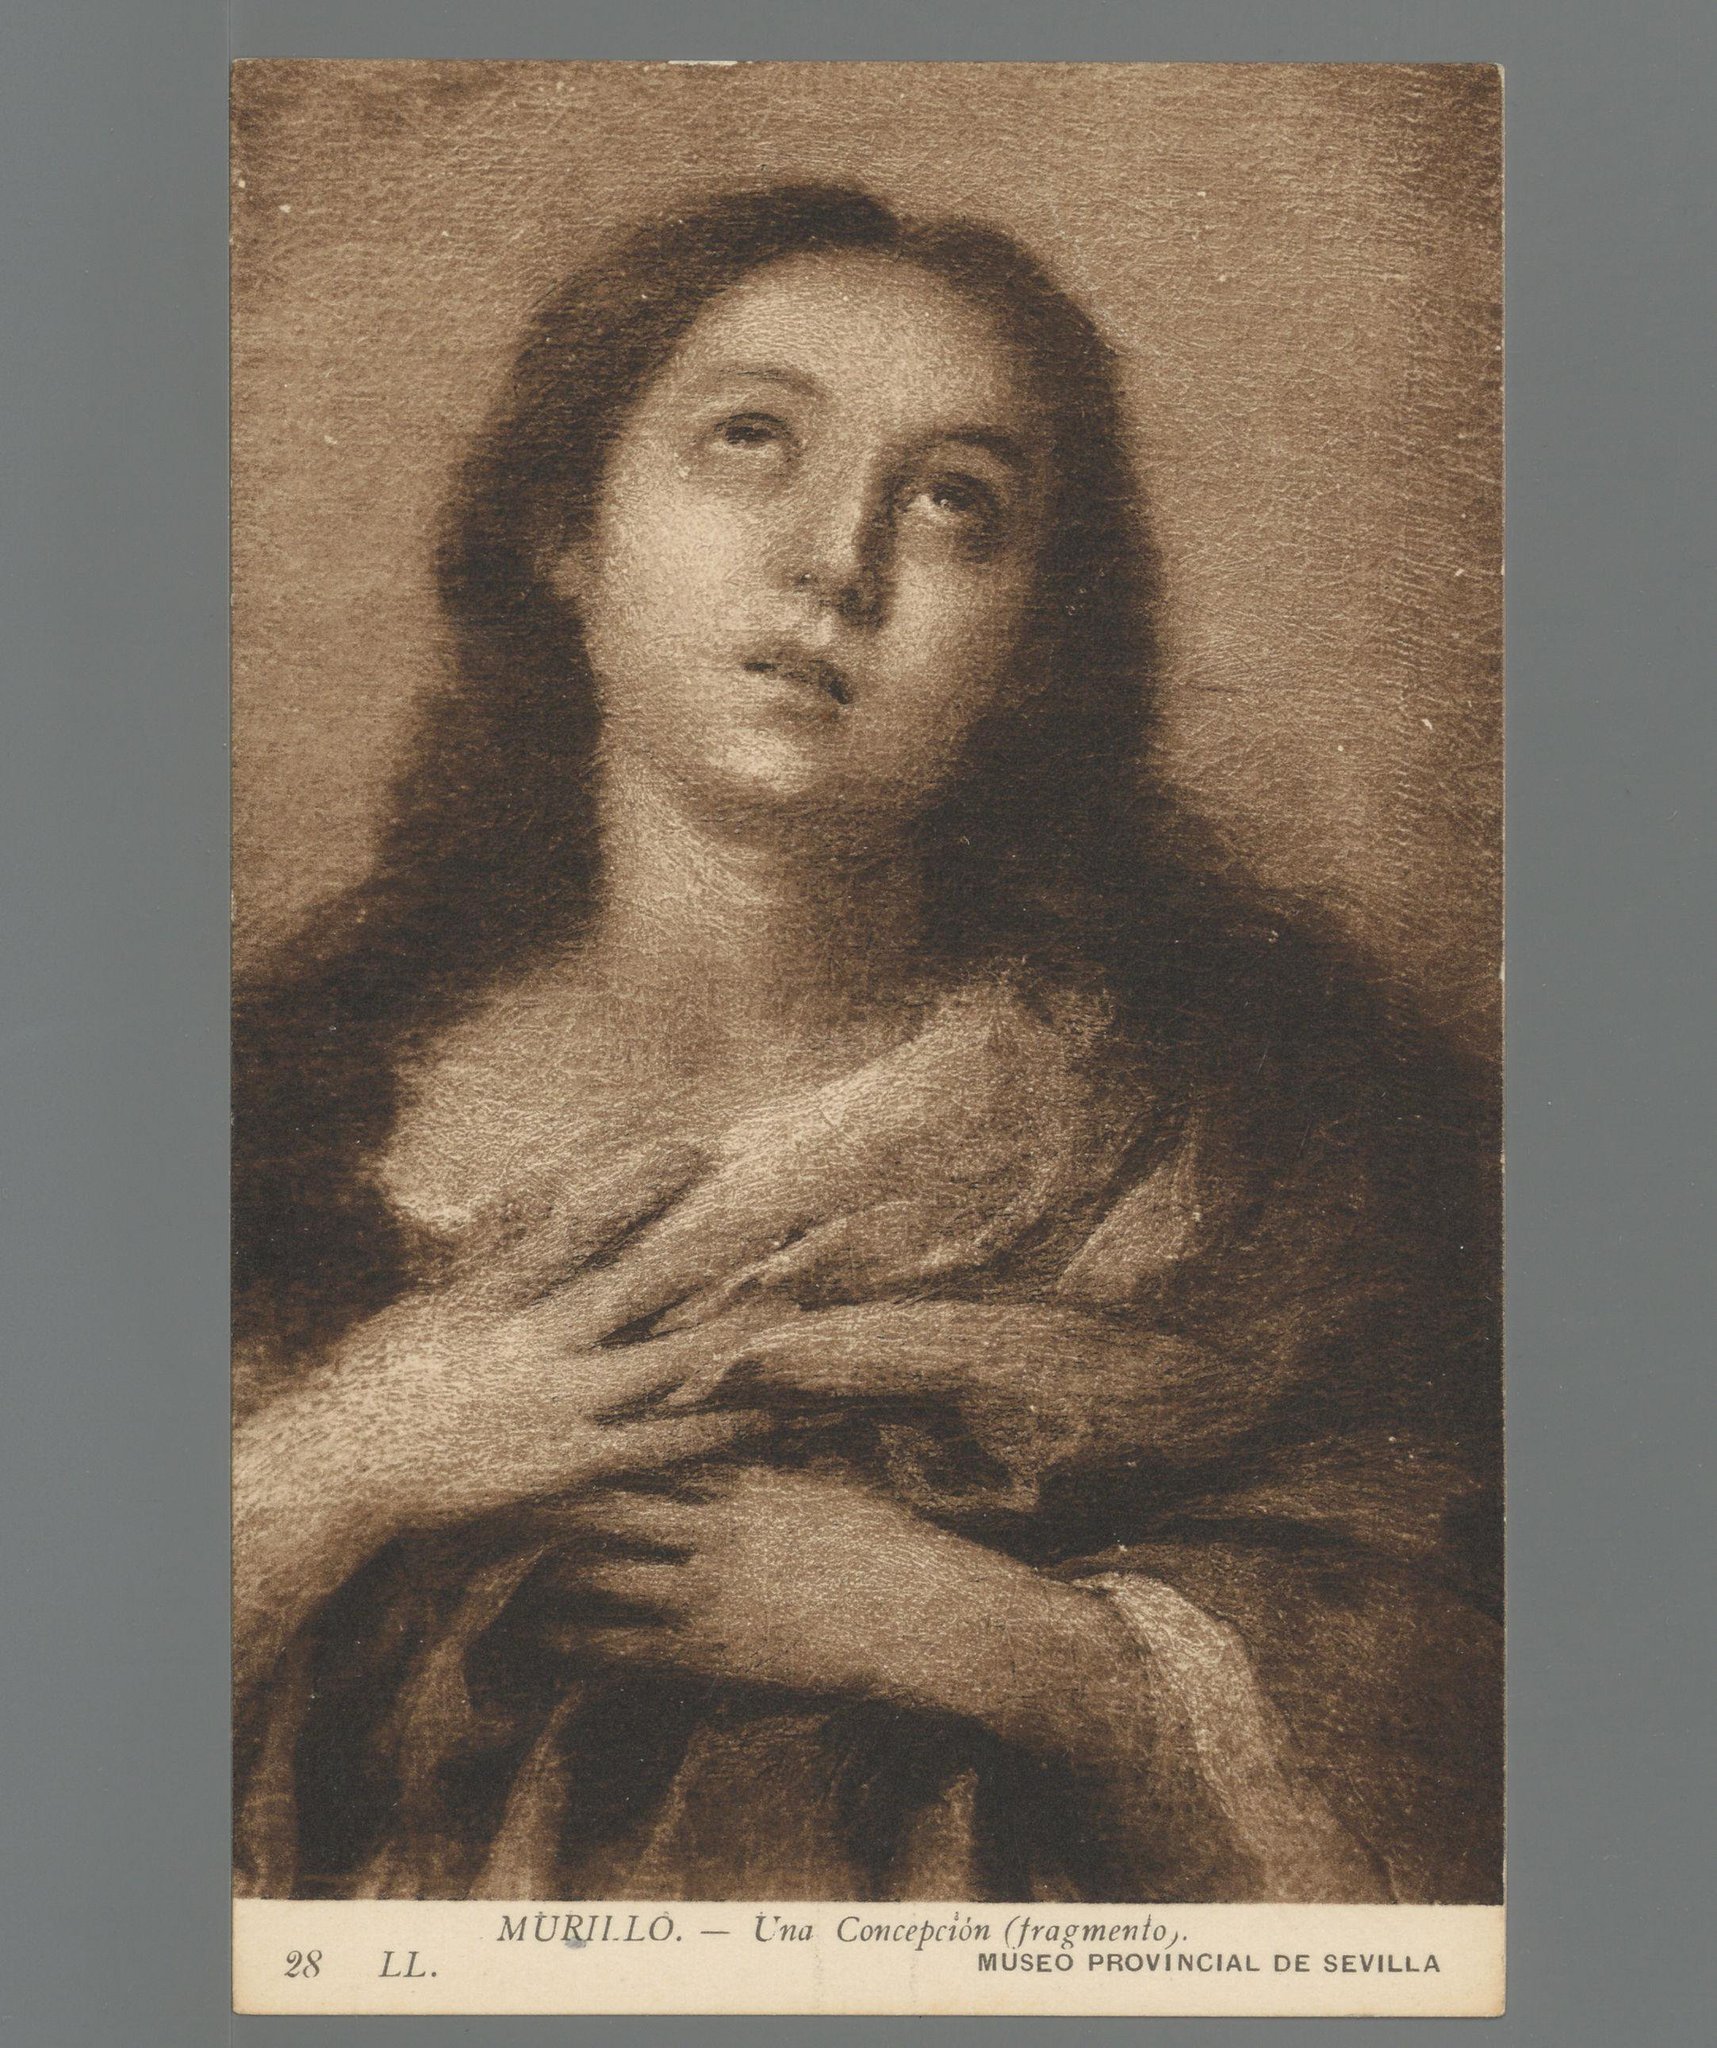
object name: ansichtkaart, prentbriefkaart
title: Una Concepción (fragmento)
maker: murillo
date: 1905-1920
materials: cardboard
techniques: photograph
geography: sevilla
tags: mary (without the christ-child)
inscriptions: collector's mark: ‘AFE v S’